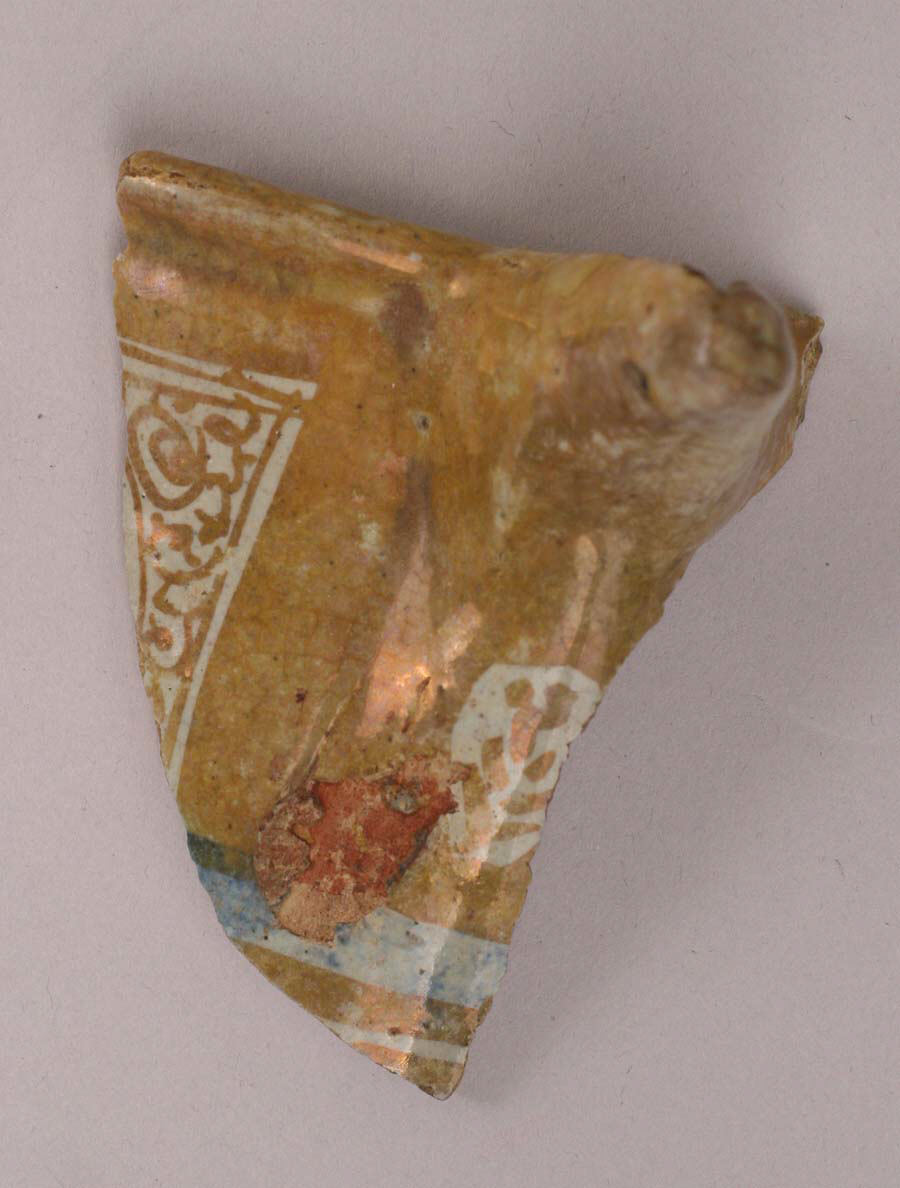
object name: fragment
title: Ceramic Fragment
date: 1401-1500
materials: earthenware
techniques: glazing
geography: spain